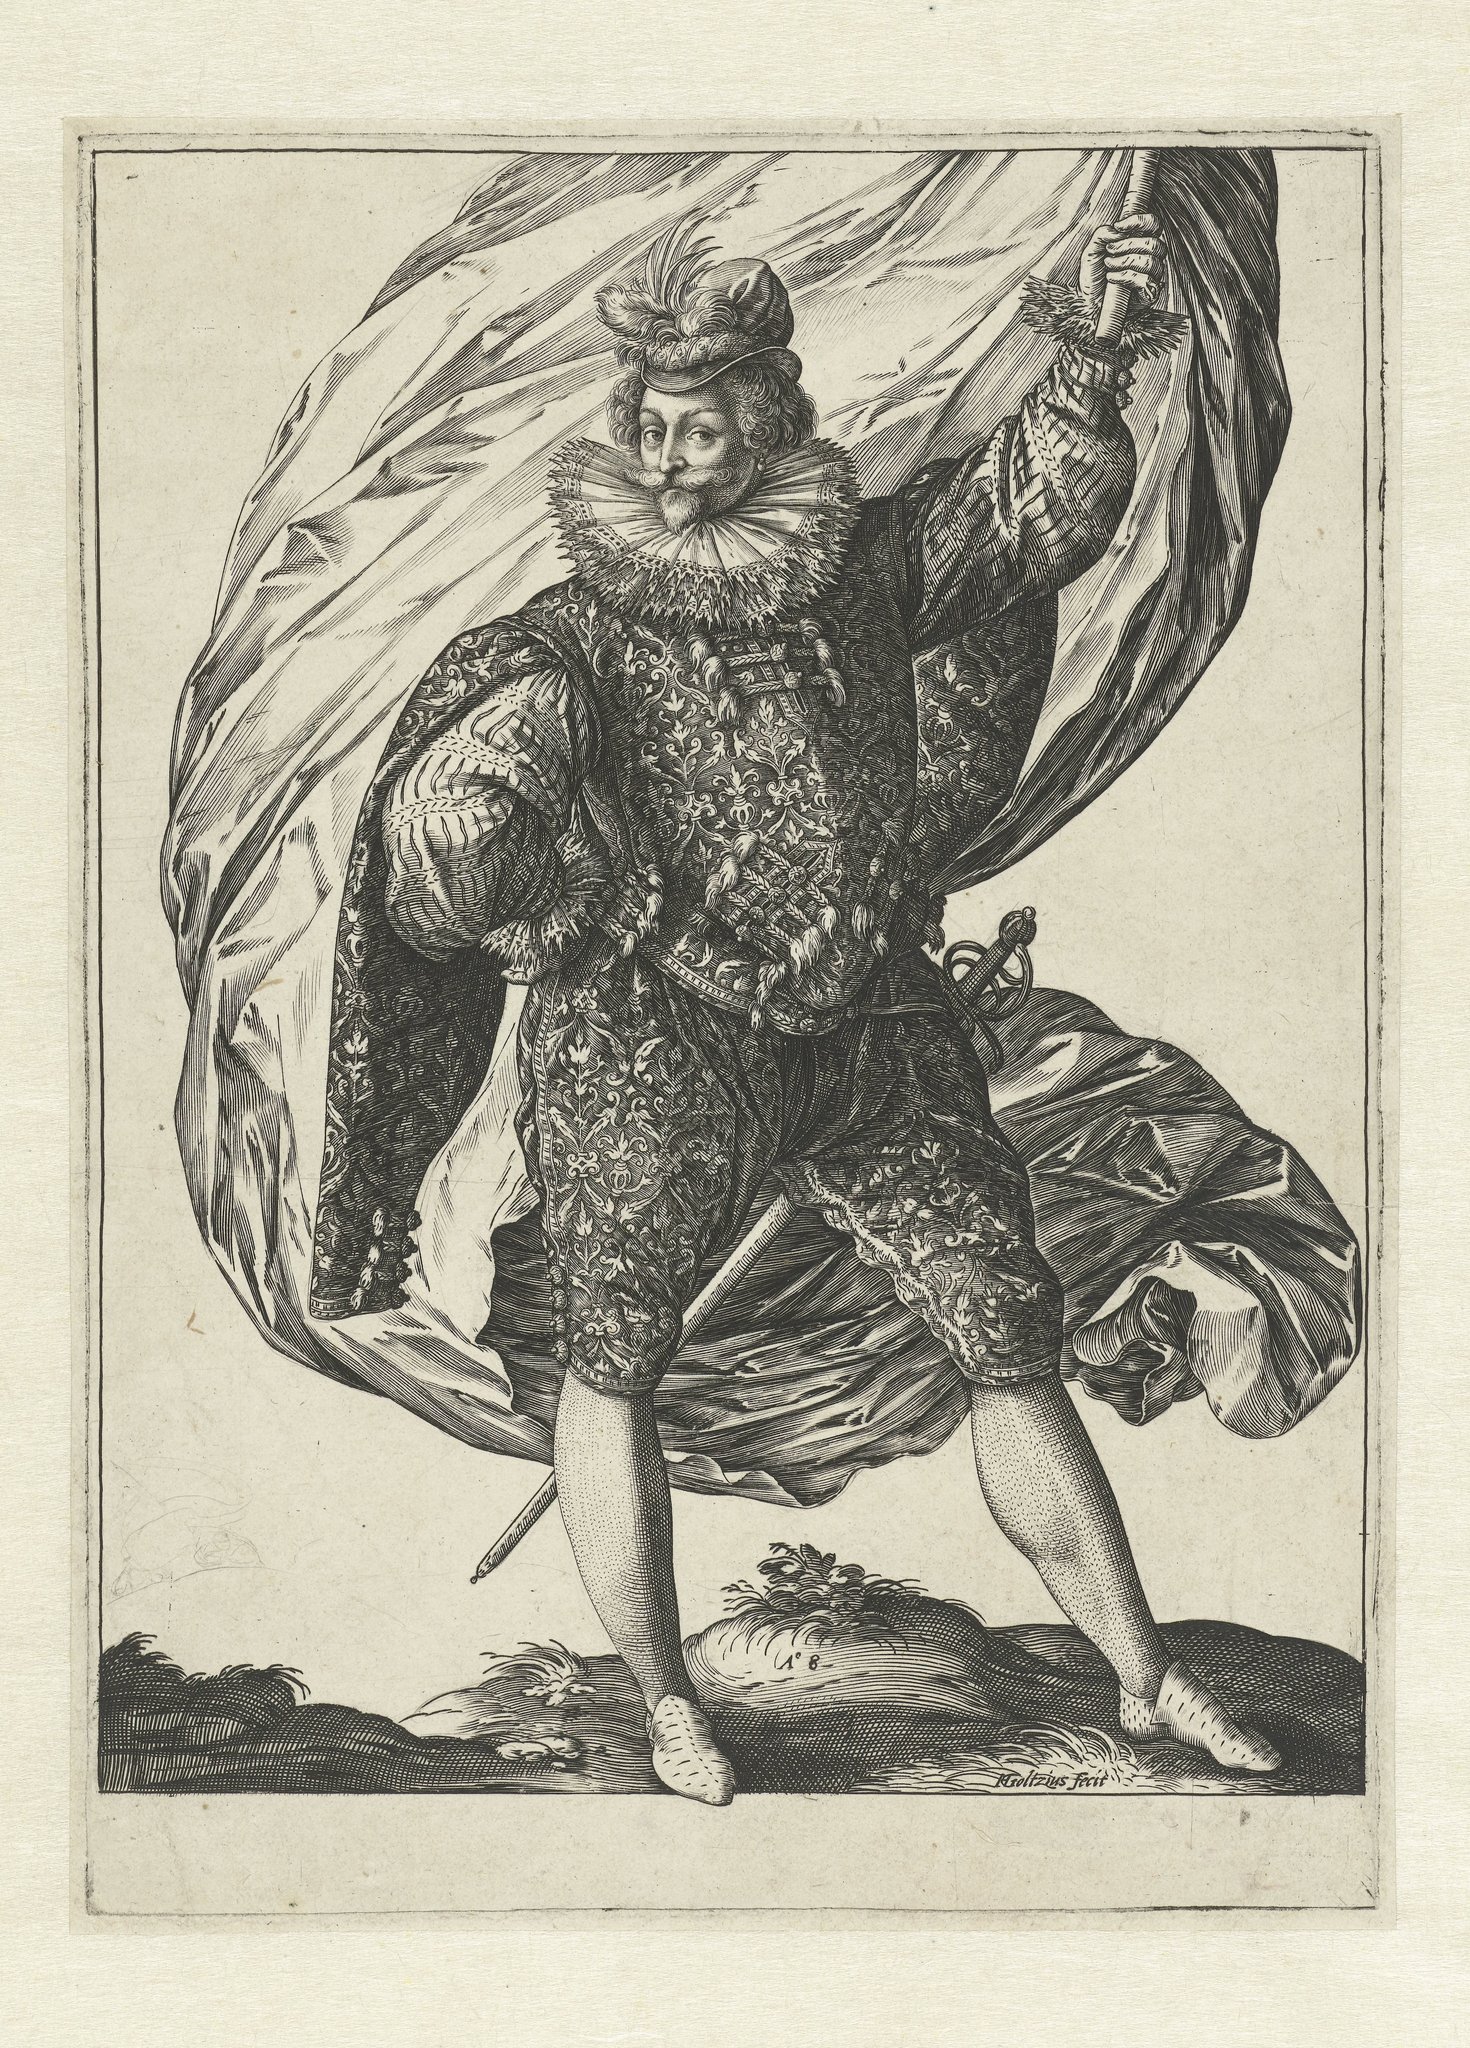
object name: print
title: Vaandrig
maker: hendrick goltzius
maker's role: draughtsman, painter, print maker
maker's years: 1558-1617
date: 1585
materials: paper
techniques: engraving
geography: haarlem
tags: (military) standard-bearer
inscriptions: collector's mark: Lugt 240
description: Portret van een man met een vaandel in zijn linkerhand. Geidentificeerd als Gerrit Pietersz. Ruychaver. Onvoltooid: achtergrond en marge onder de prent zijn leeg gelaten.